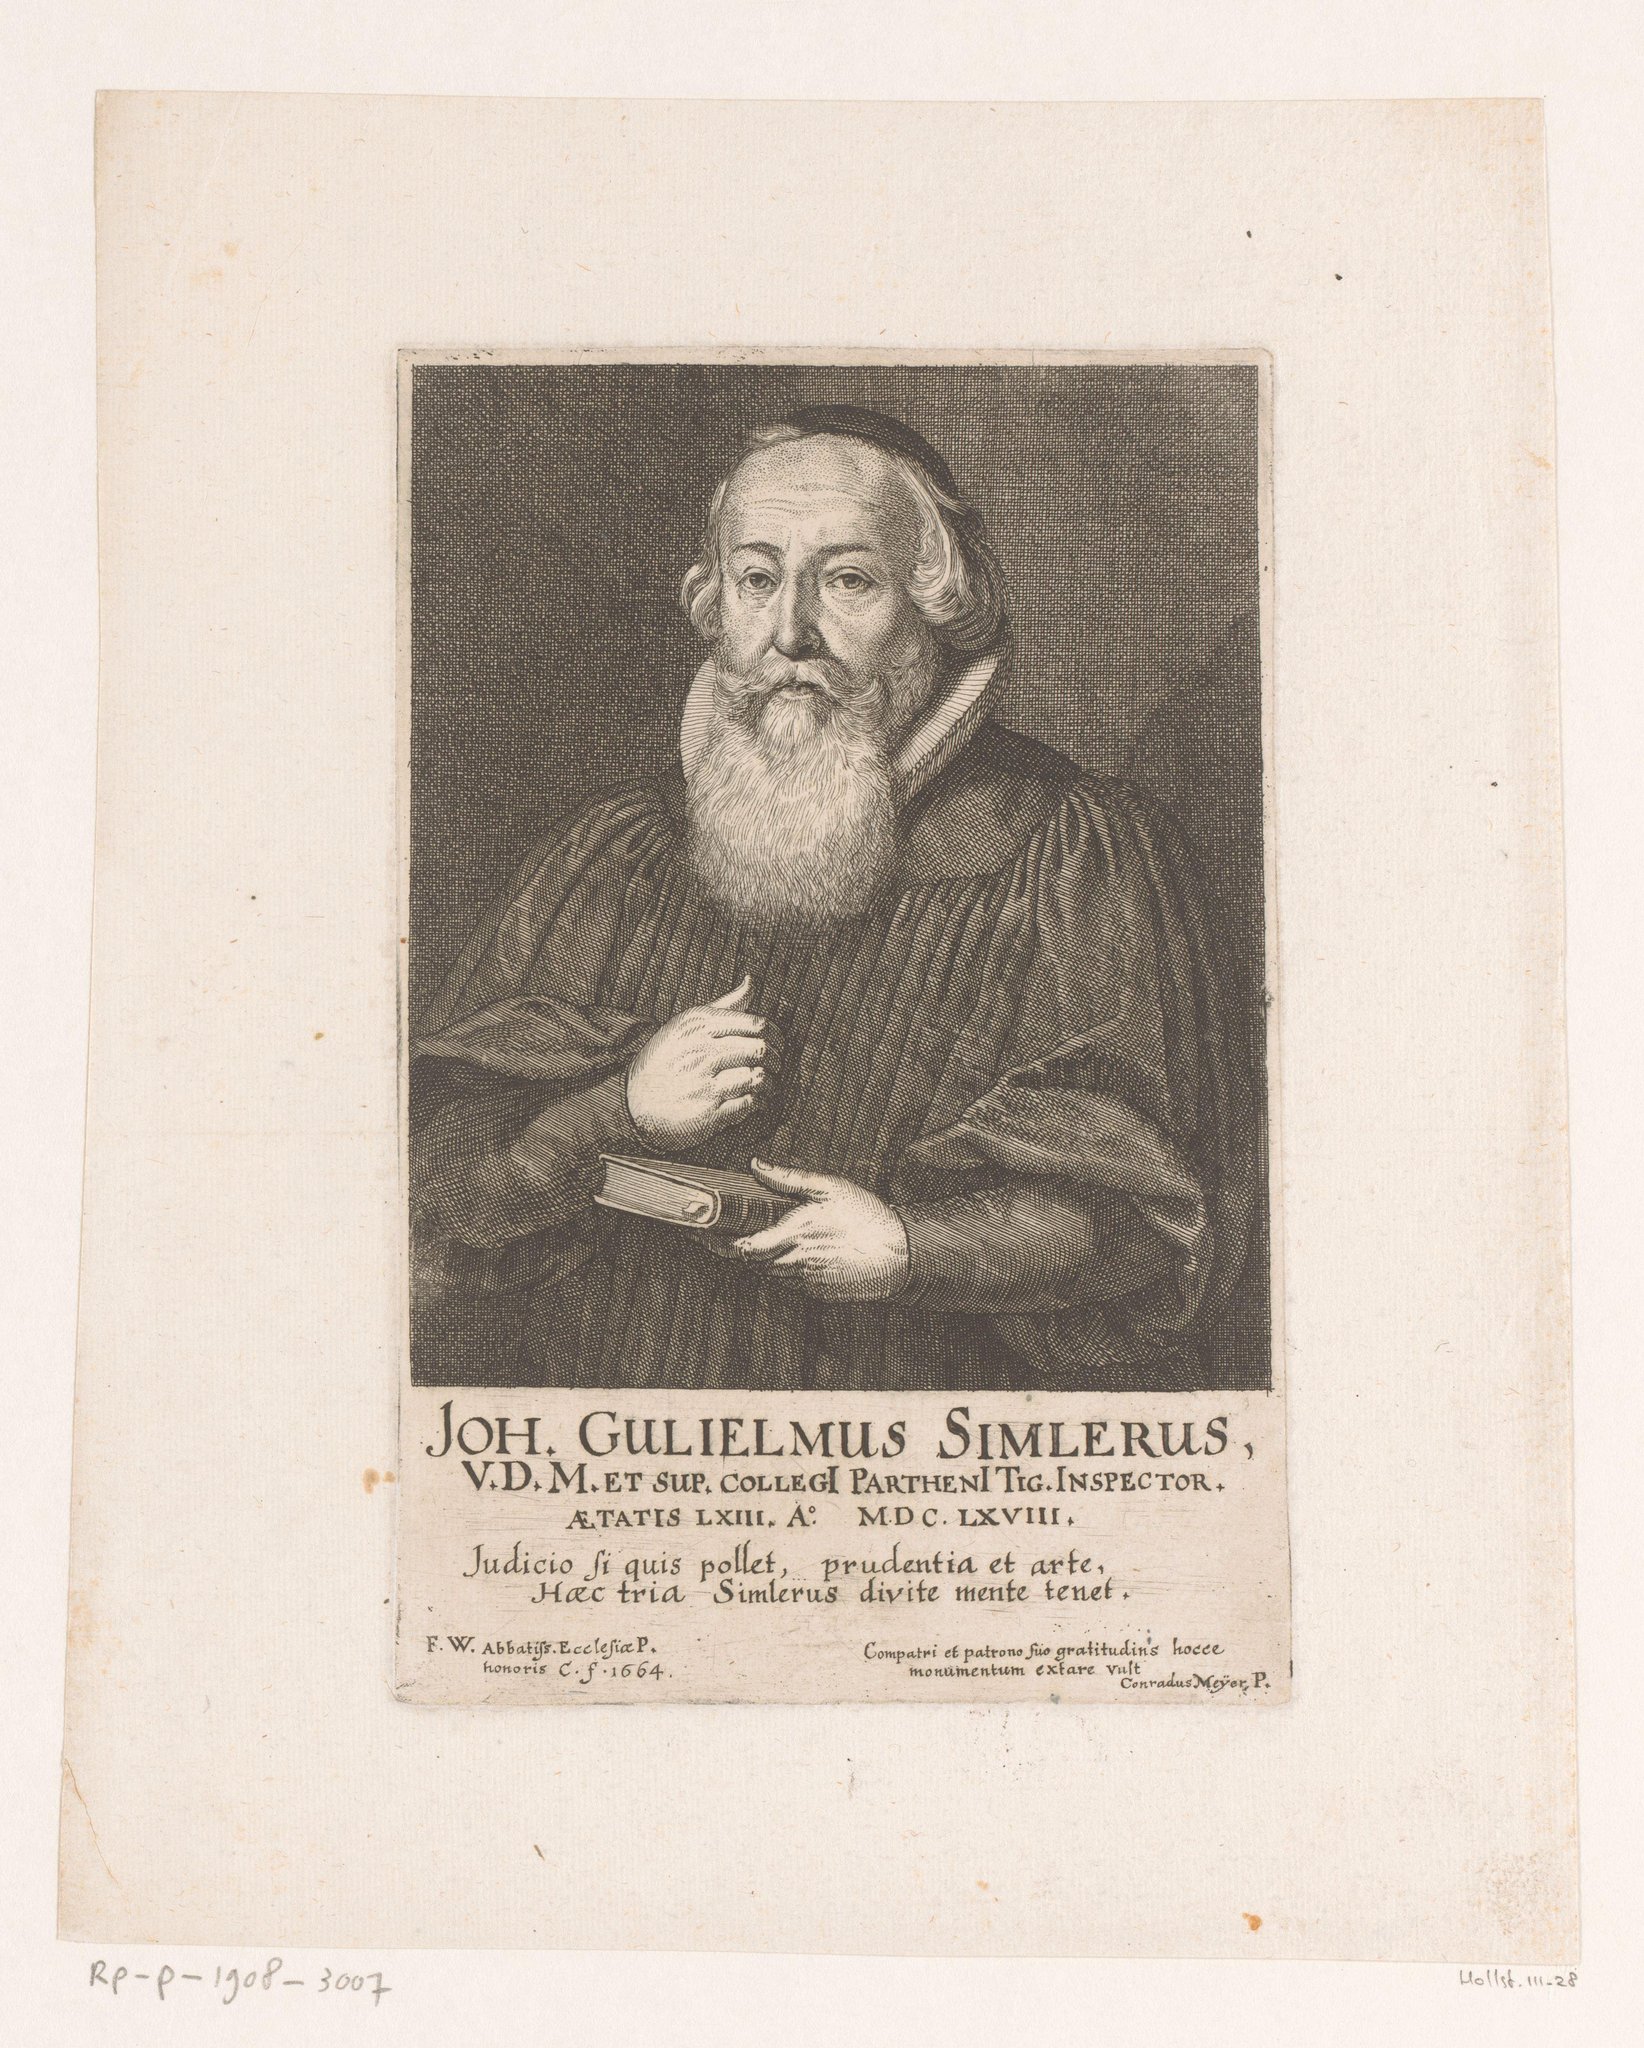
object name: print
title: Portretten van priesters van Zürich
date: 1664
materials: paper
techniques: engraving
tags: theologian, historical persons, book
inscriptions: collector's mark: Lugt 2228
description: Onderdeel van een serie van 62 portretten van priesters en theologen van Zürich. Zie Hollstein German 111, 1-41.